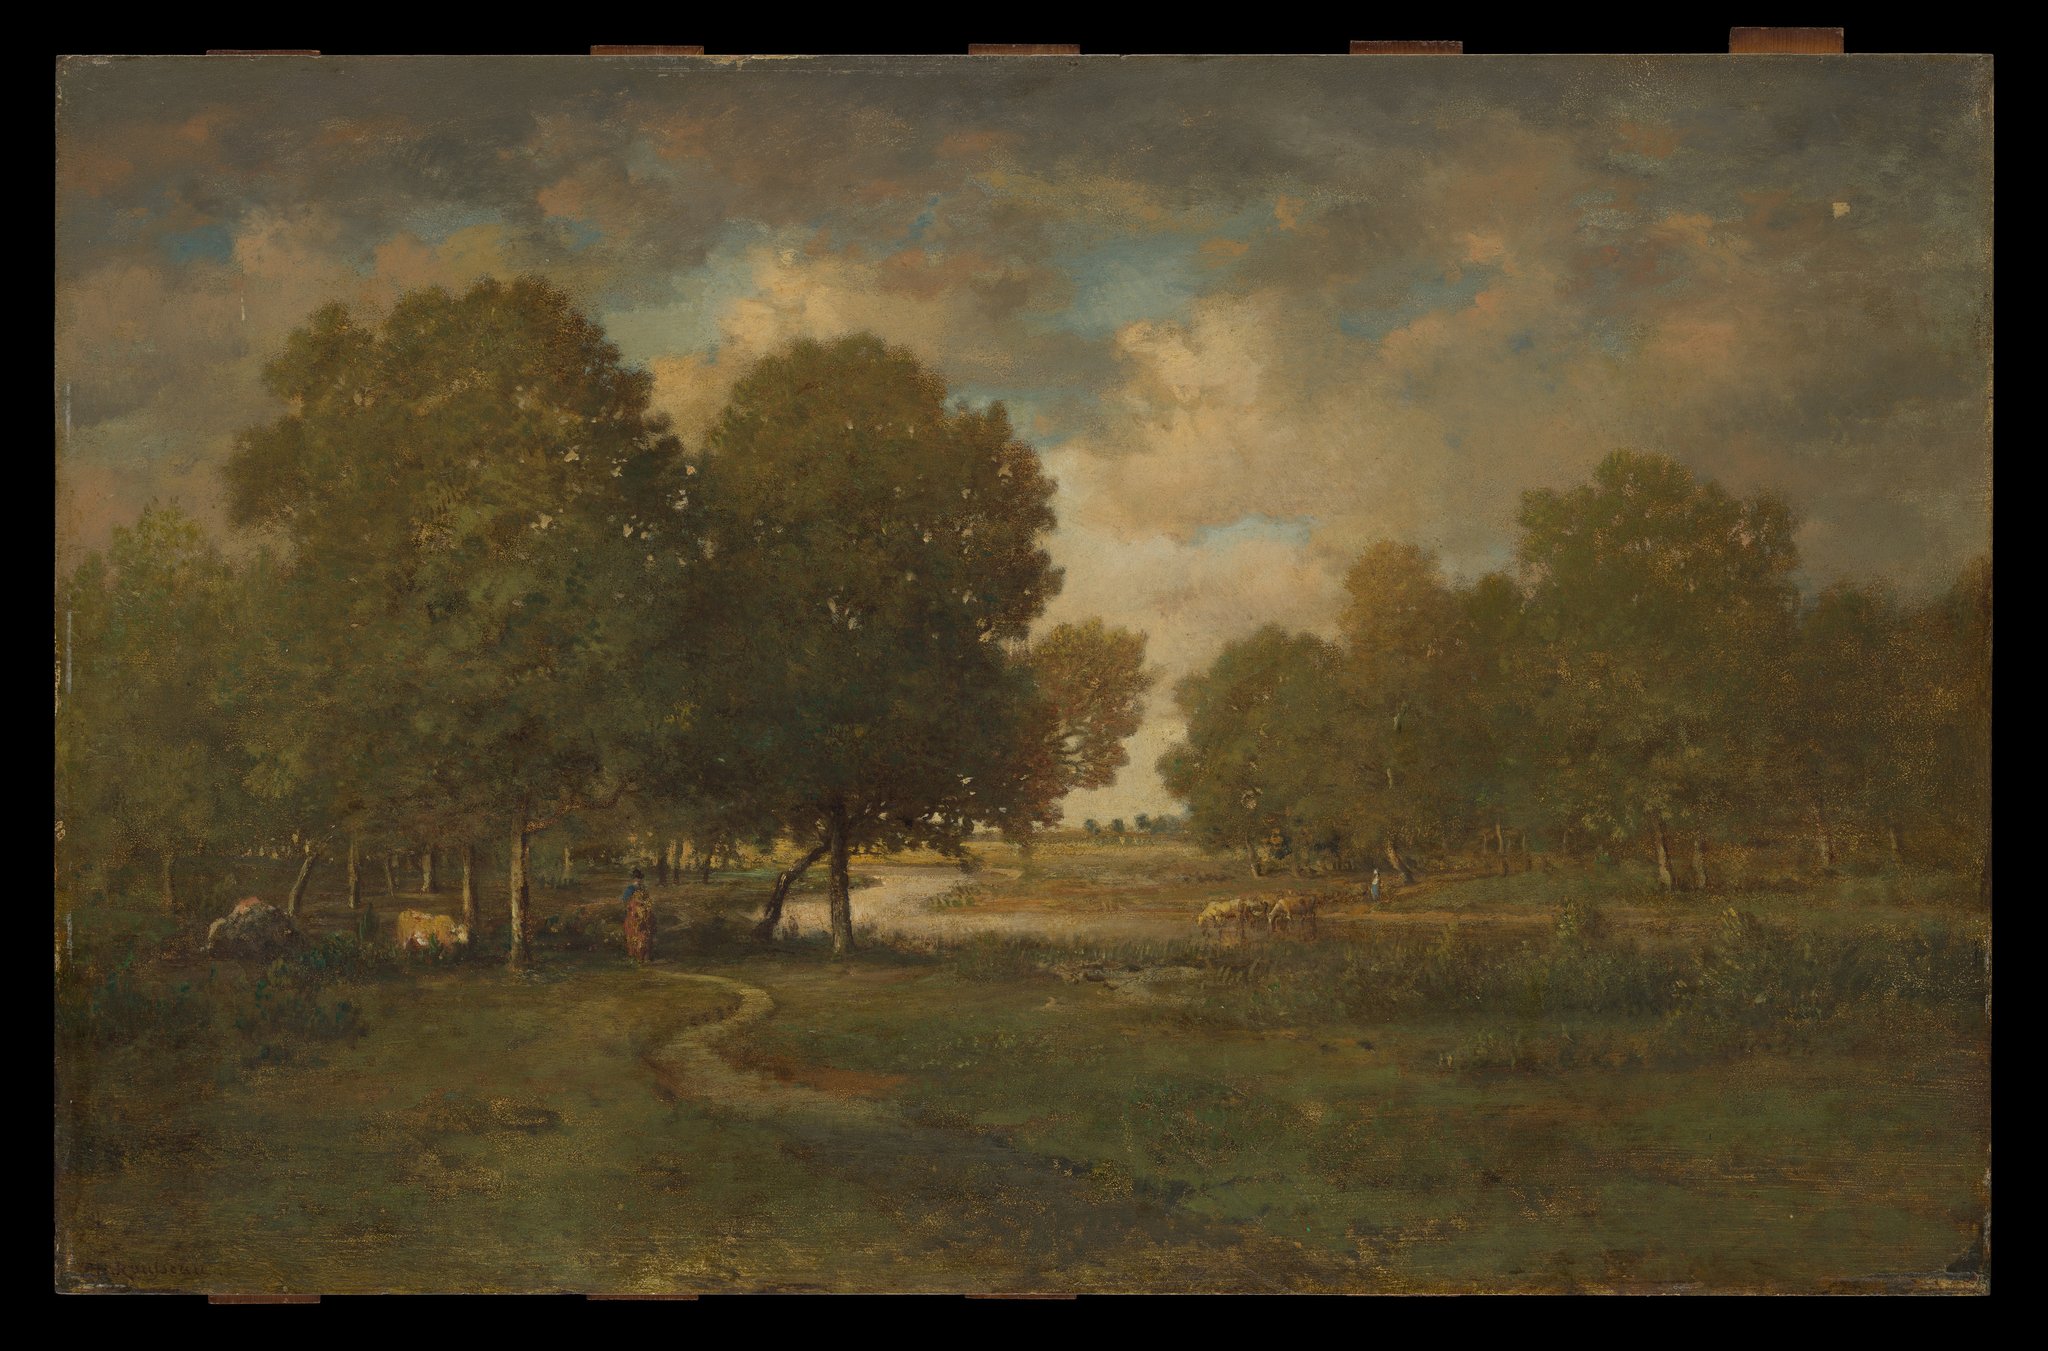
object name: painting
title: A River in a Meadow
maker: théodore rousseau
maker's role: artist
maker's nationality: french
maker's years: 1812-1867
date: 1840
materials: oil, wood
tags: cows,rivers,landscapes